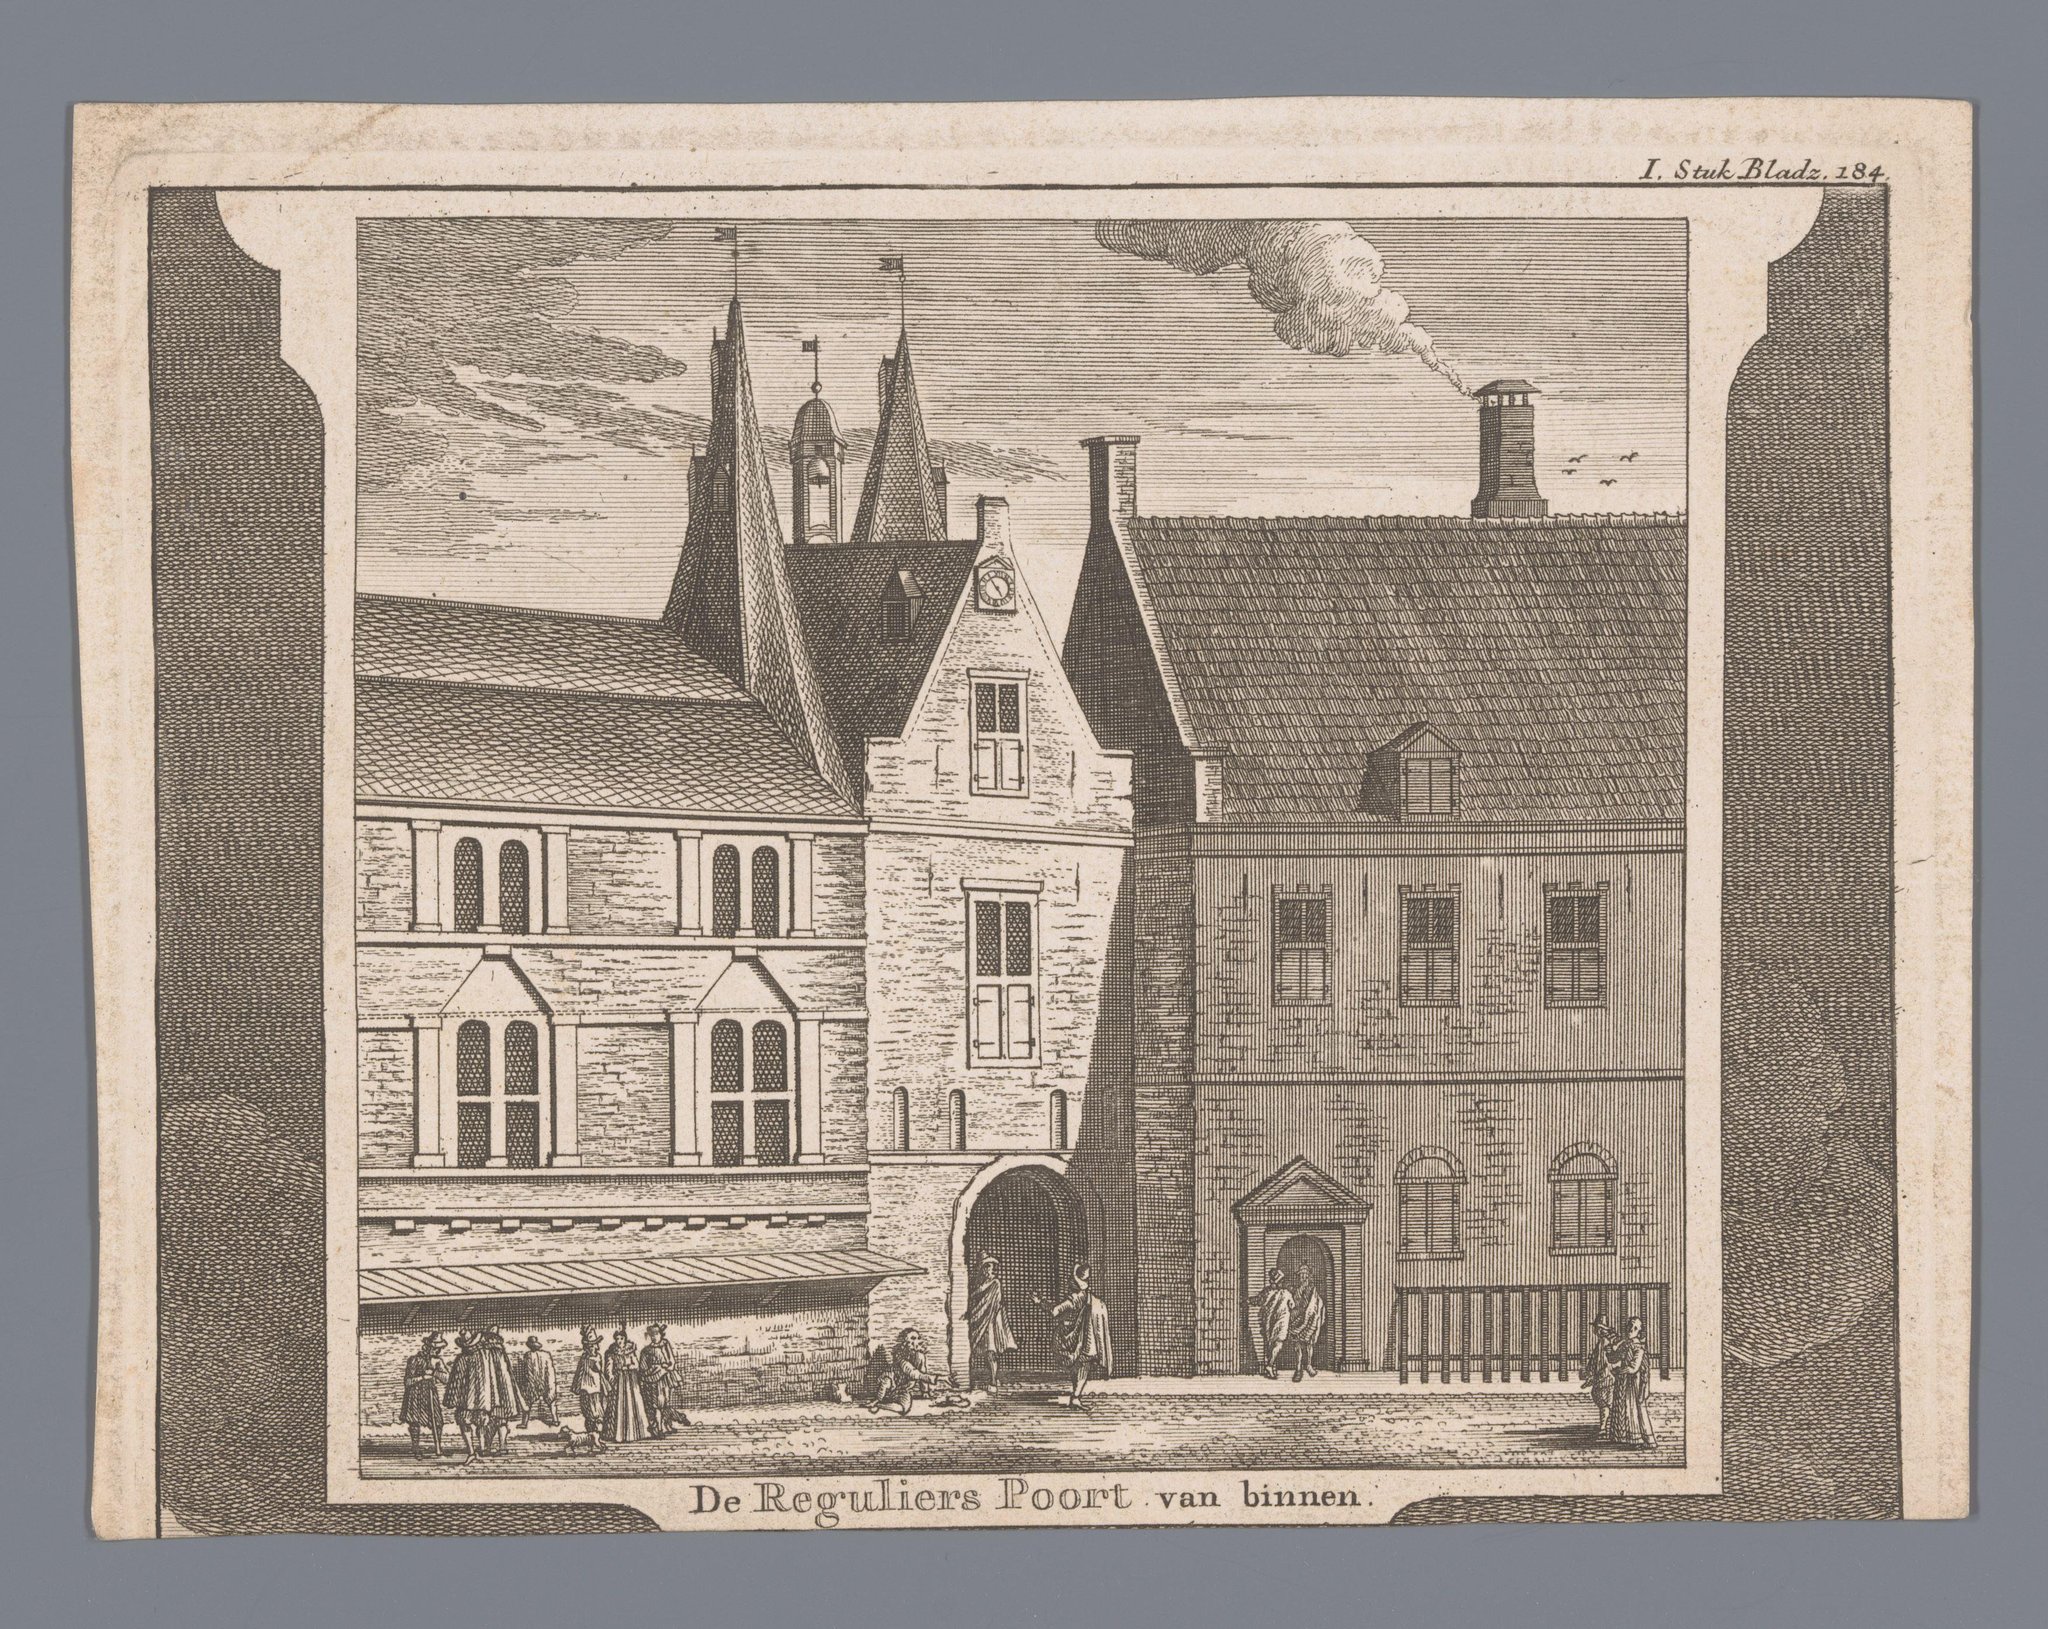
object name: print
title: De Reguliers poort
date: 1663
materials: paper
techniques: etching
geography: amsterdam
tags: rowing-boat, canoe, etc., windmill in landscape, bridge in city across river, canal, etc., city-gate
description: Prent uit: Dapper, Olfert. Historische beschryving der stadt Amsterdam (...). Amsterdam: Jacob van Meurs, 1663, tussen p. 450-451. Een identieke versie van de prent bestaat met een Frans opschrift boven het Nederlandse opschrift.